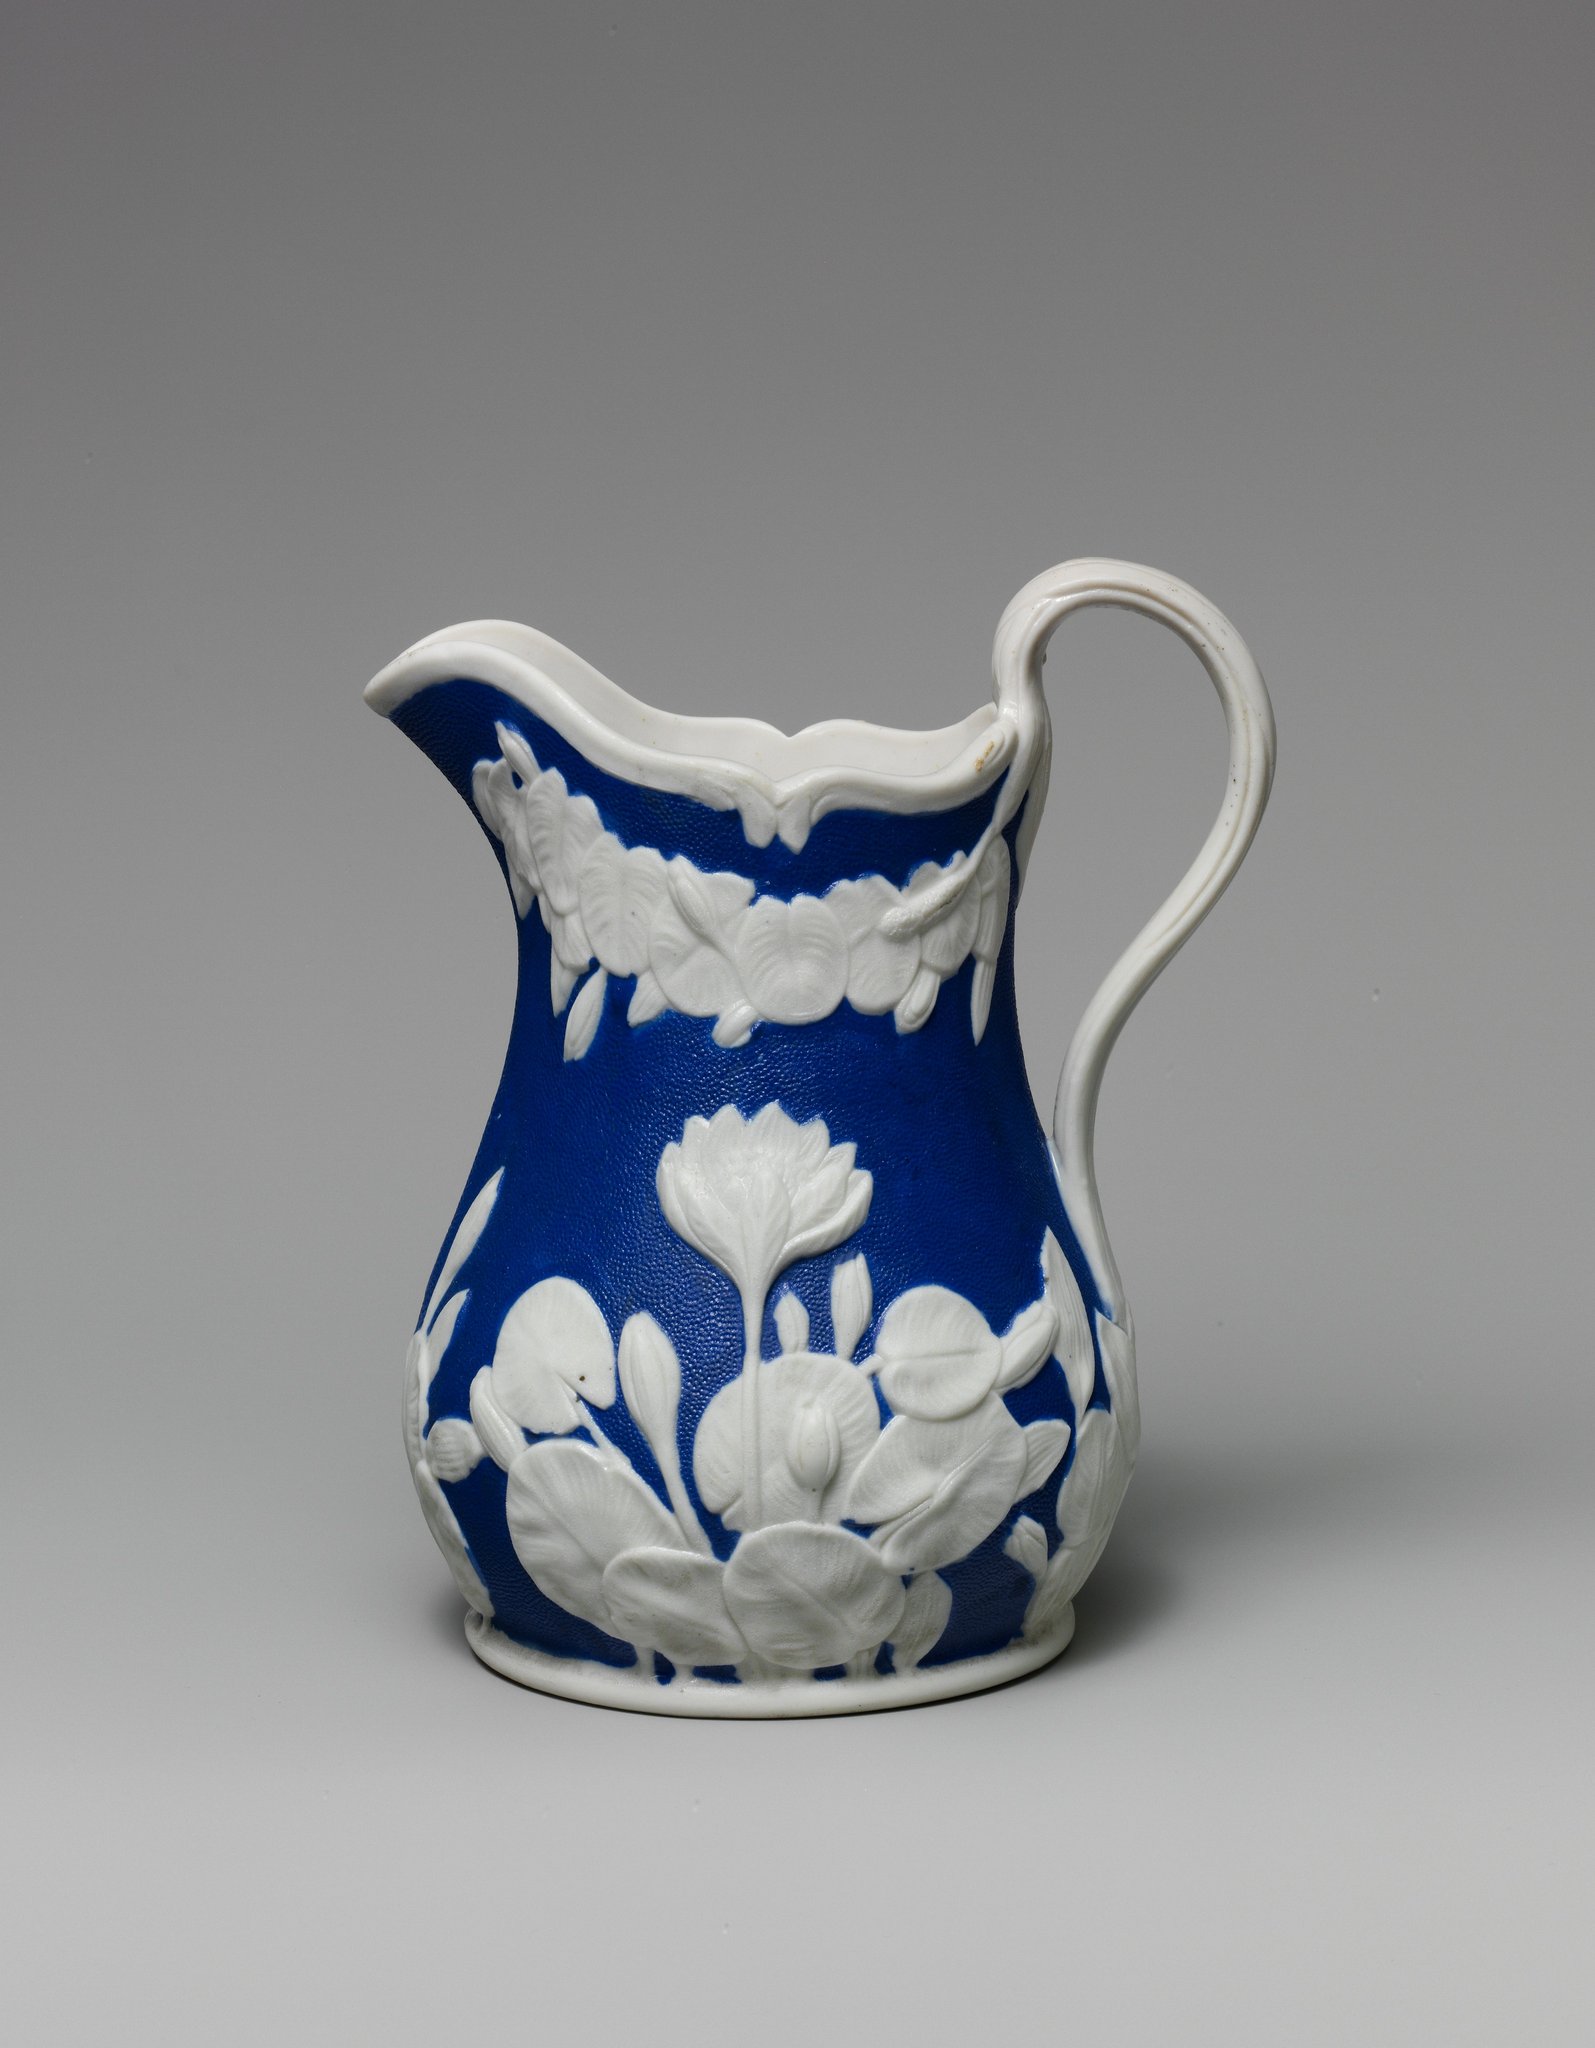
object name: pitcher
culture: american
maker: united states pottery company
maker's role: maker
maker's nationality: american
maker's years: 1852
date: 1852-1858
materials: porcelain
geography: united states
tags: flowers